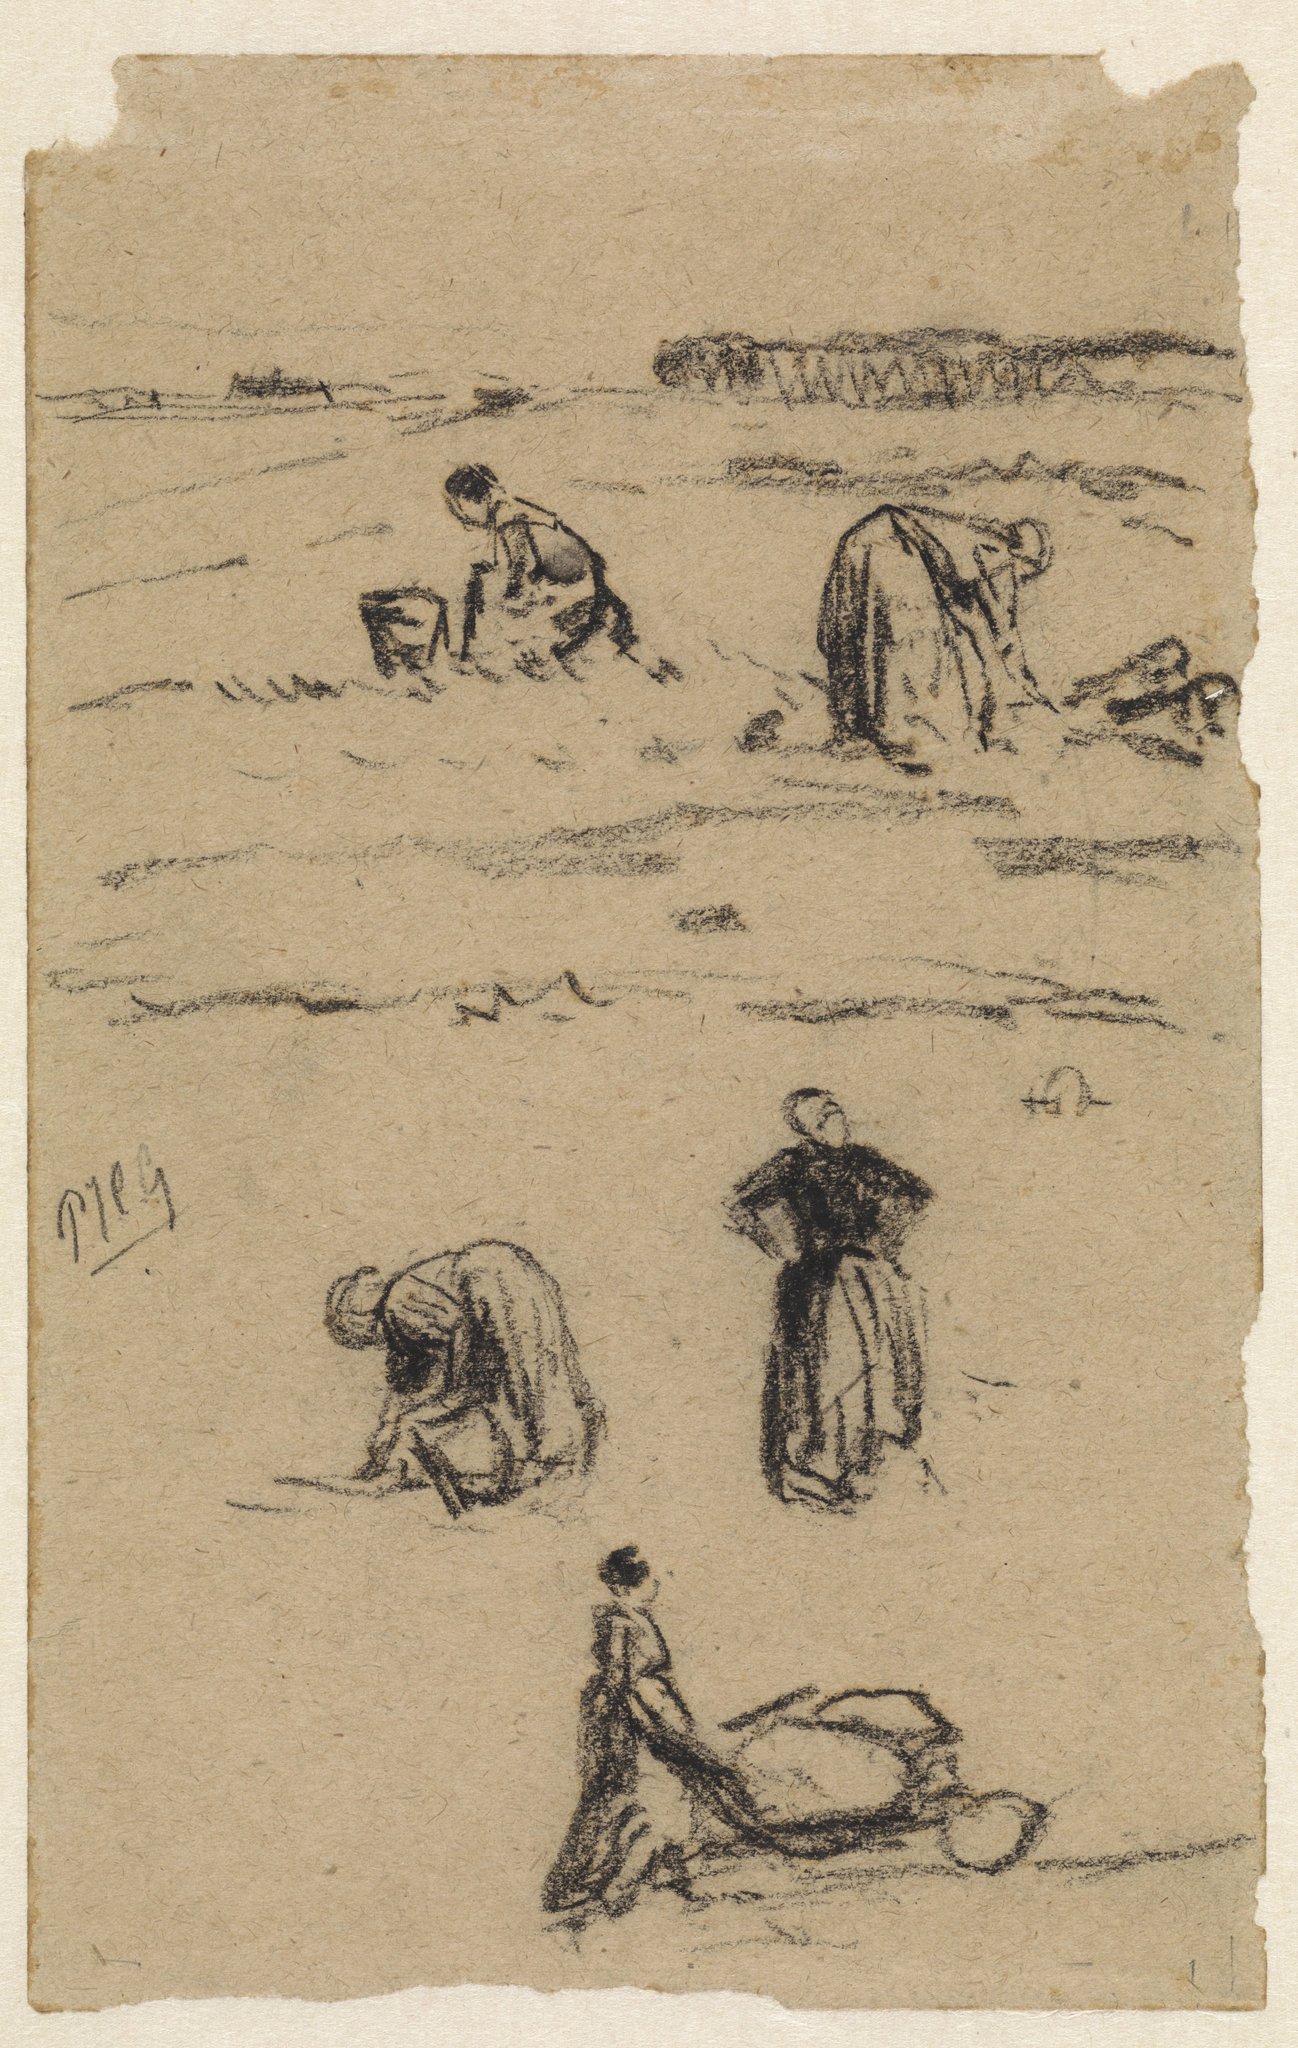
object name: drawing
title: Studies van vrouwen op het land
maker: paul joseph constantin gabriël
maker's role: draughtsman, print maker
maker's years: 1828-1903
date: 1838-1903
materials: chalk, paper